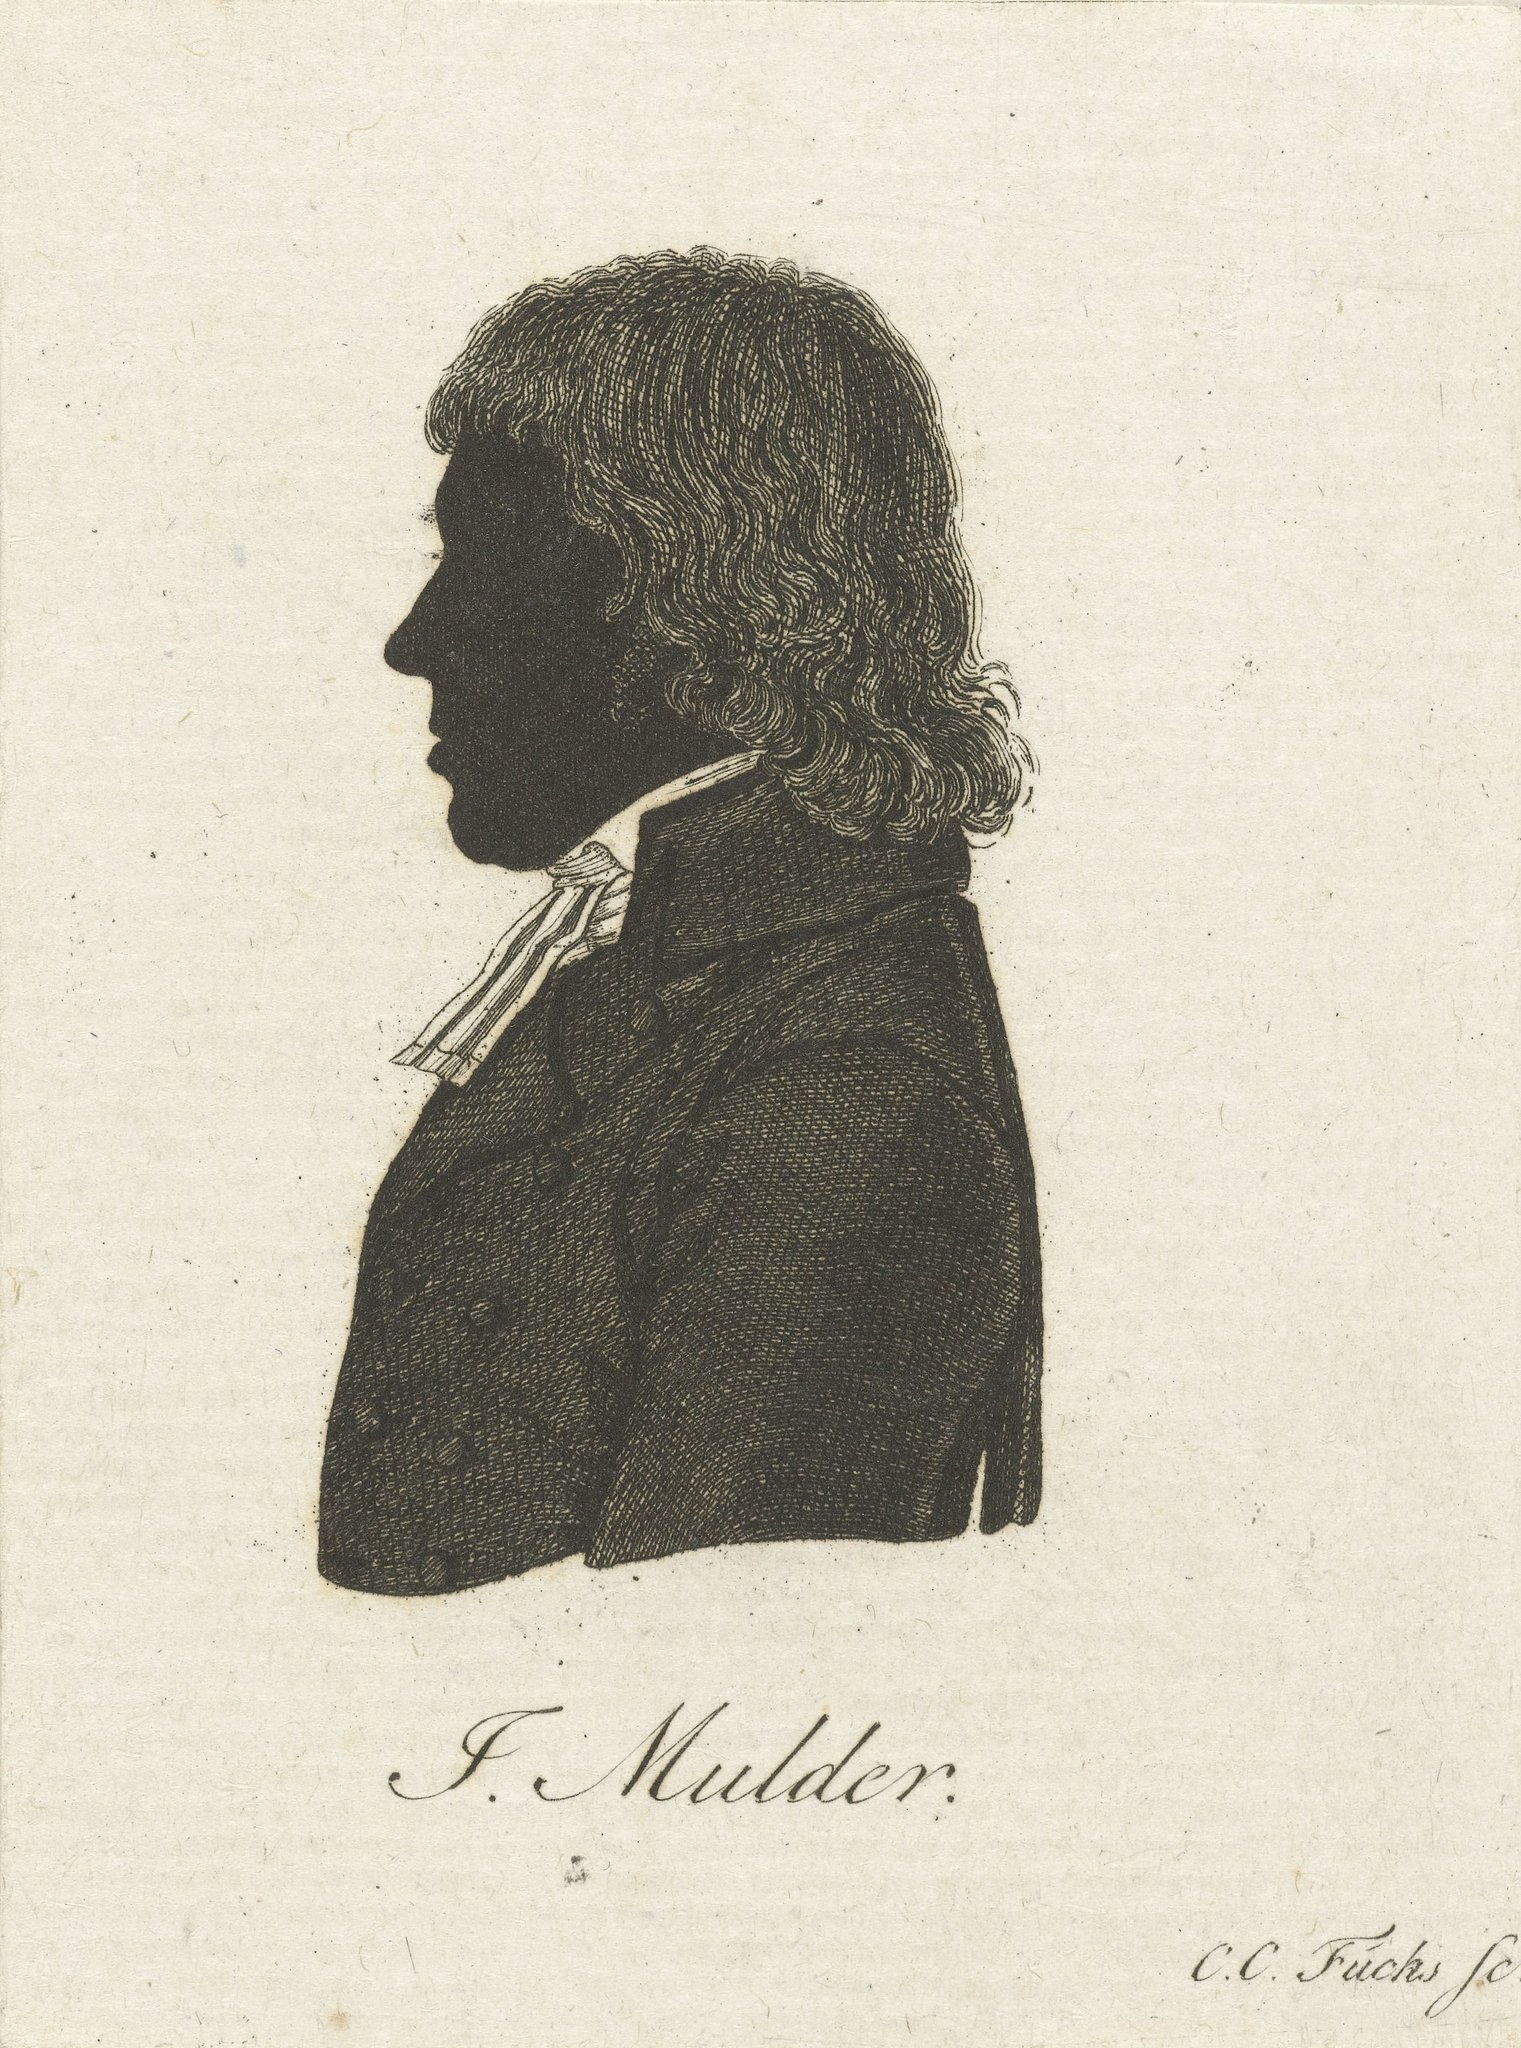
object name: print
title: Silhouetportret van Johannes Mulder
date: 1808-1844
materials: paper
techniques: etching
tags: veendam, groningen, predikant, johannes mulder (1775-1832)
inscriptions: collector's mark: Lugt 2228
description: Silhouetportret van Johannes Mulder, buste naar links.